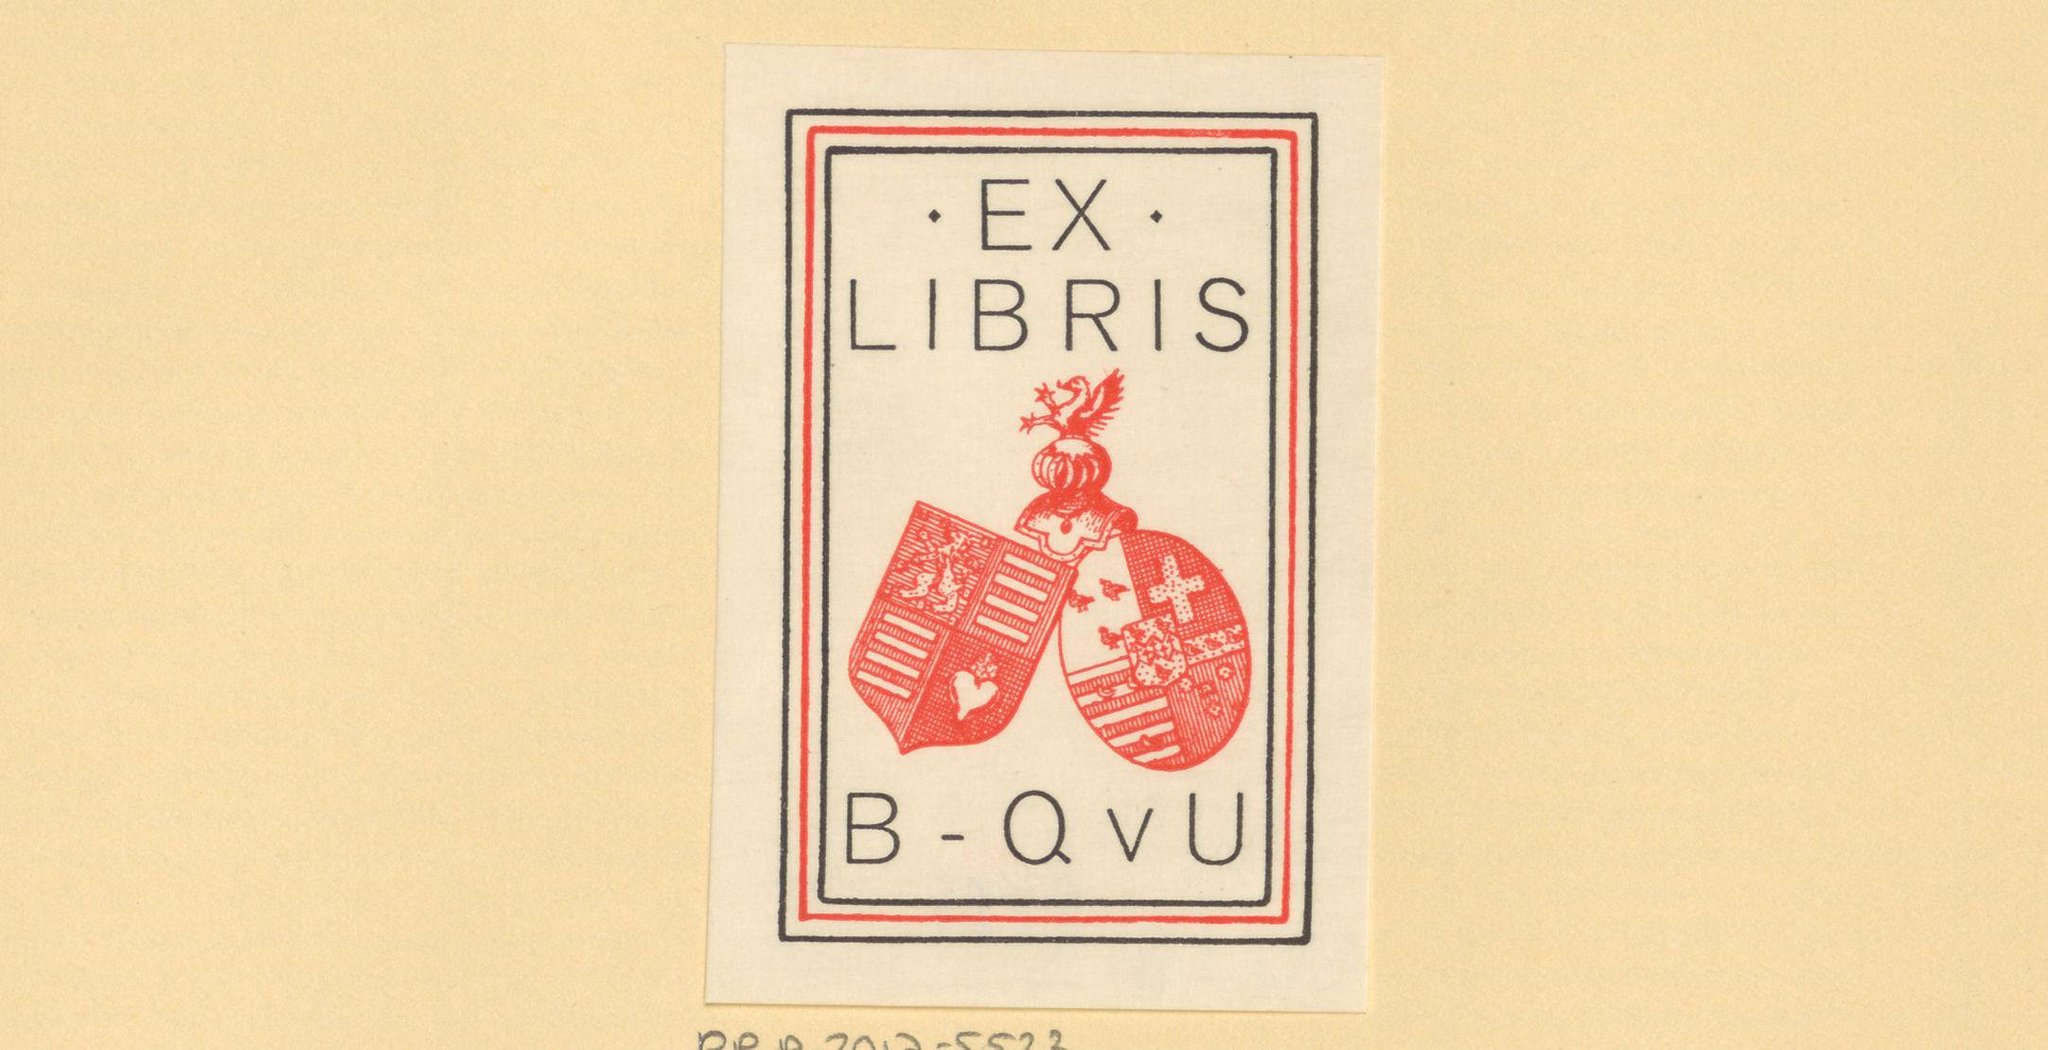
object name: bookplate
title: B-Q.v.U.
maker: Anonymous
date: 1925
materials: paper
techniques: printing block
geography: netherlands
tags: dordrecht, armorial bearing, heraldry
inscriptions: inscription: ‘2584 / Nypels '26’